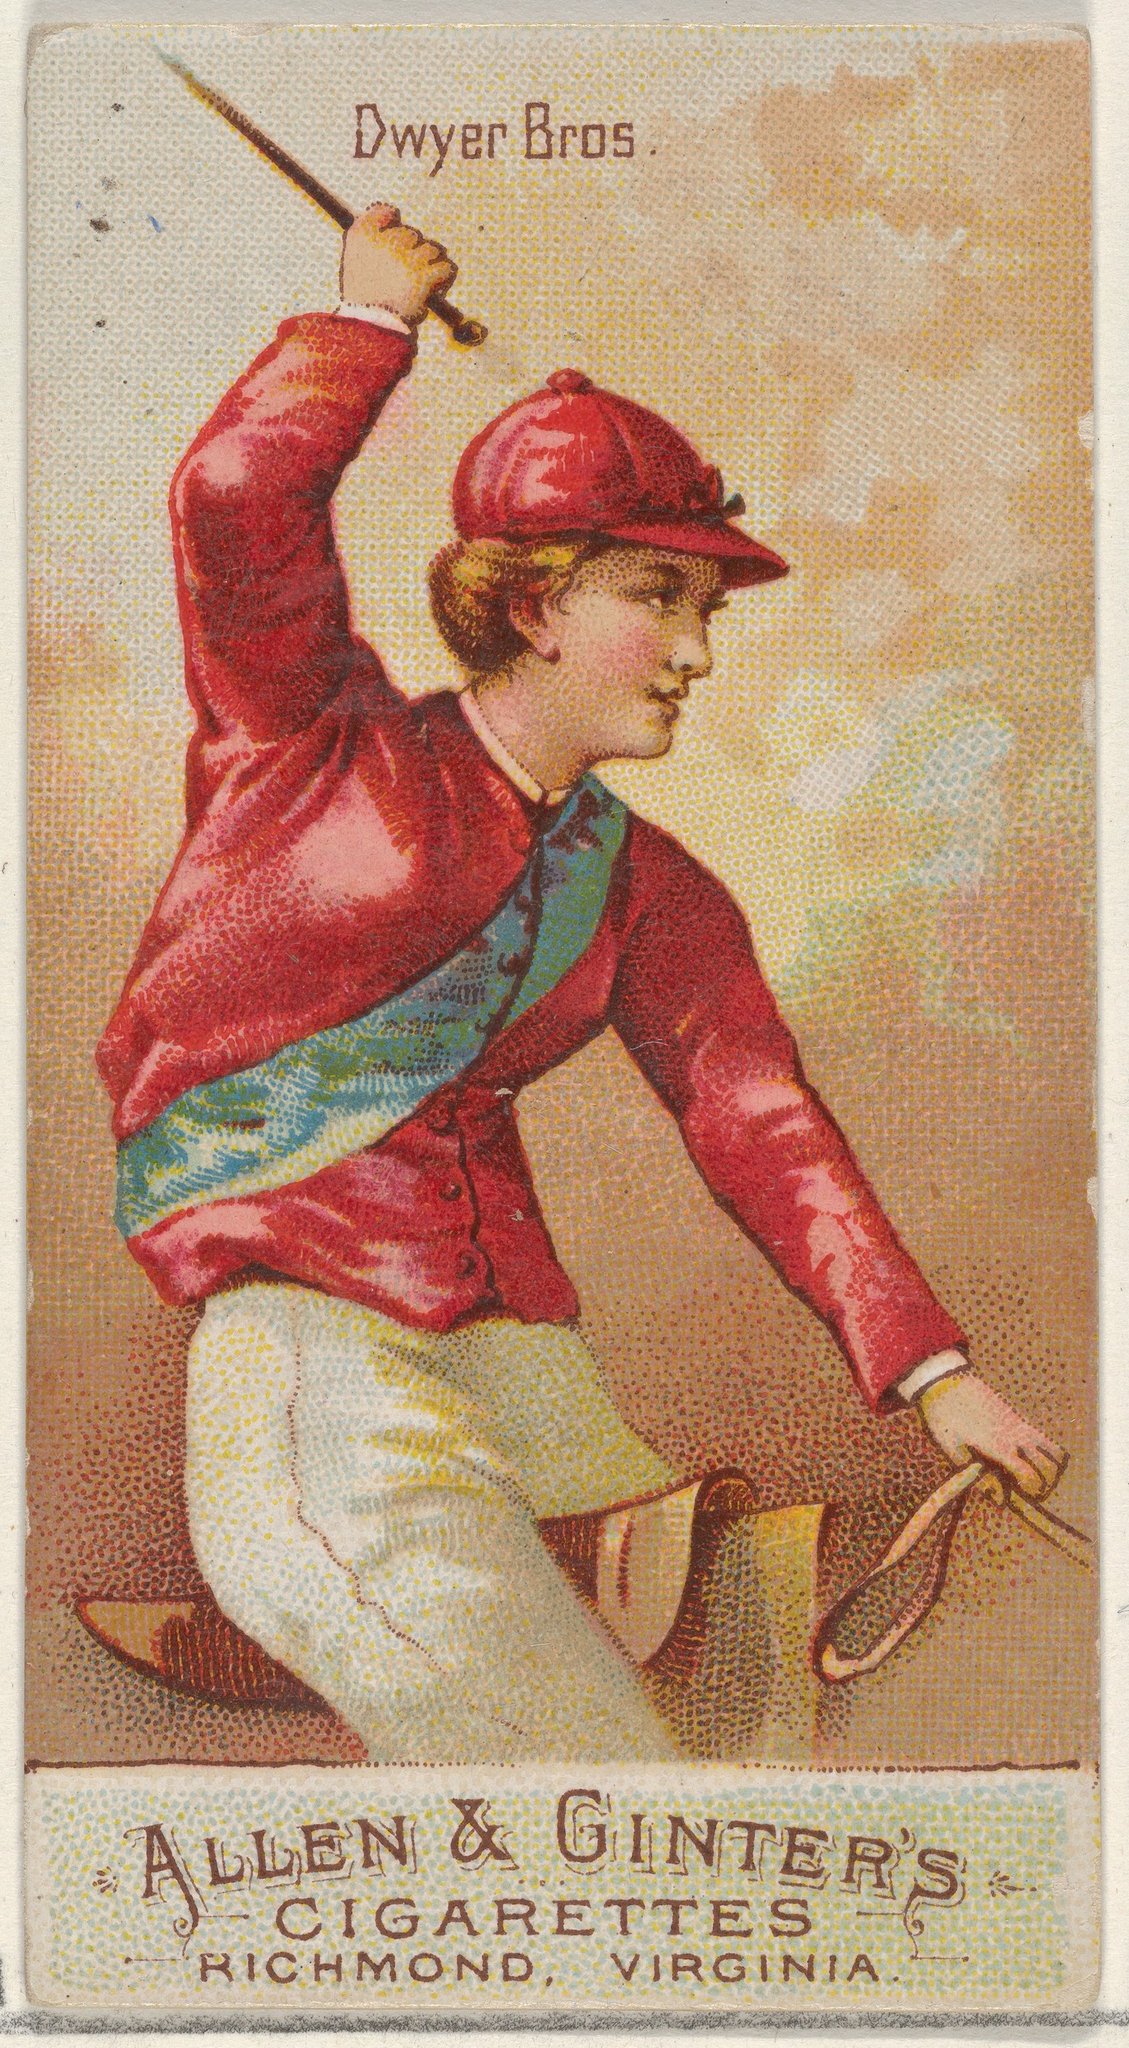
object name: print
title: Dwyer Brothers, from the Racing Colors of the World series (N22b) for Allen & Ginter Cigarettes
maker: allen & ginter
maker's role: publisher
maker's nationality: american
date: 1888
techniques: color lithograph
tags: profiles,women,jockeys